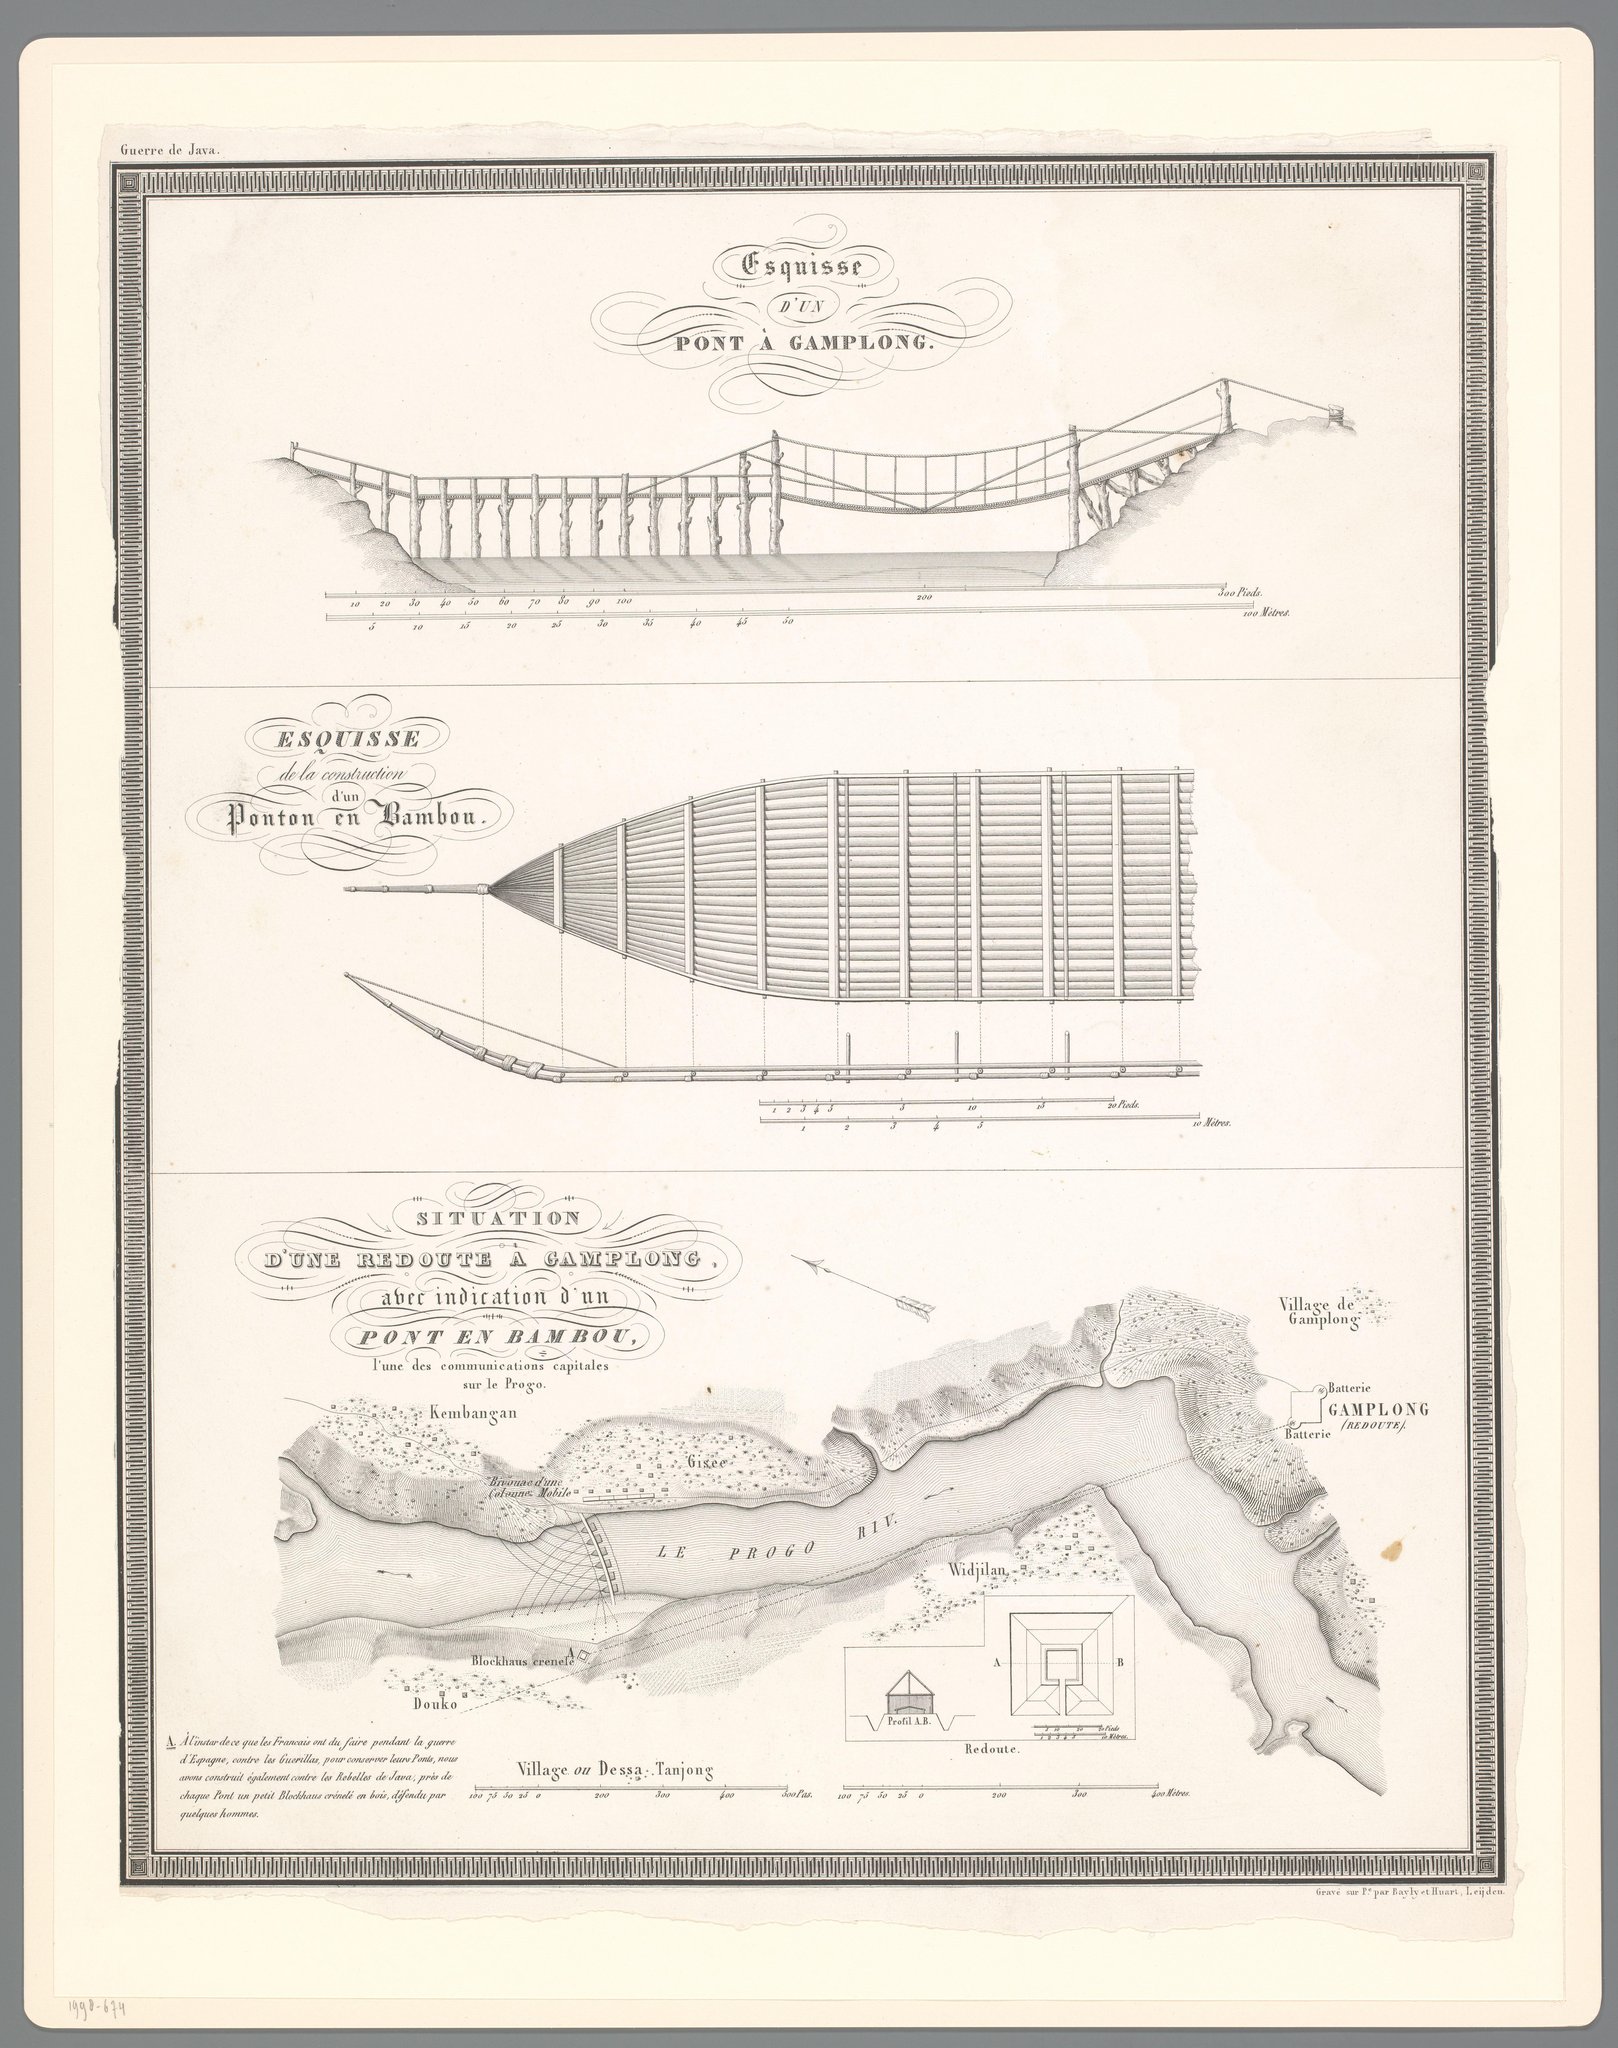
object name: print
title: Esquisse d'un Pont à Gamplong / Esquisse de la construction d'un Ponton en Bambou / Situation d'une redoute à Gamplong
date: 1825-1832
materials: paper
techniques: etching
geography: leiden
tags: river, pontoon bridge, bridge, java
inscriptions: collector's mark: Lugt 2228